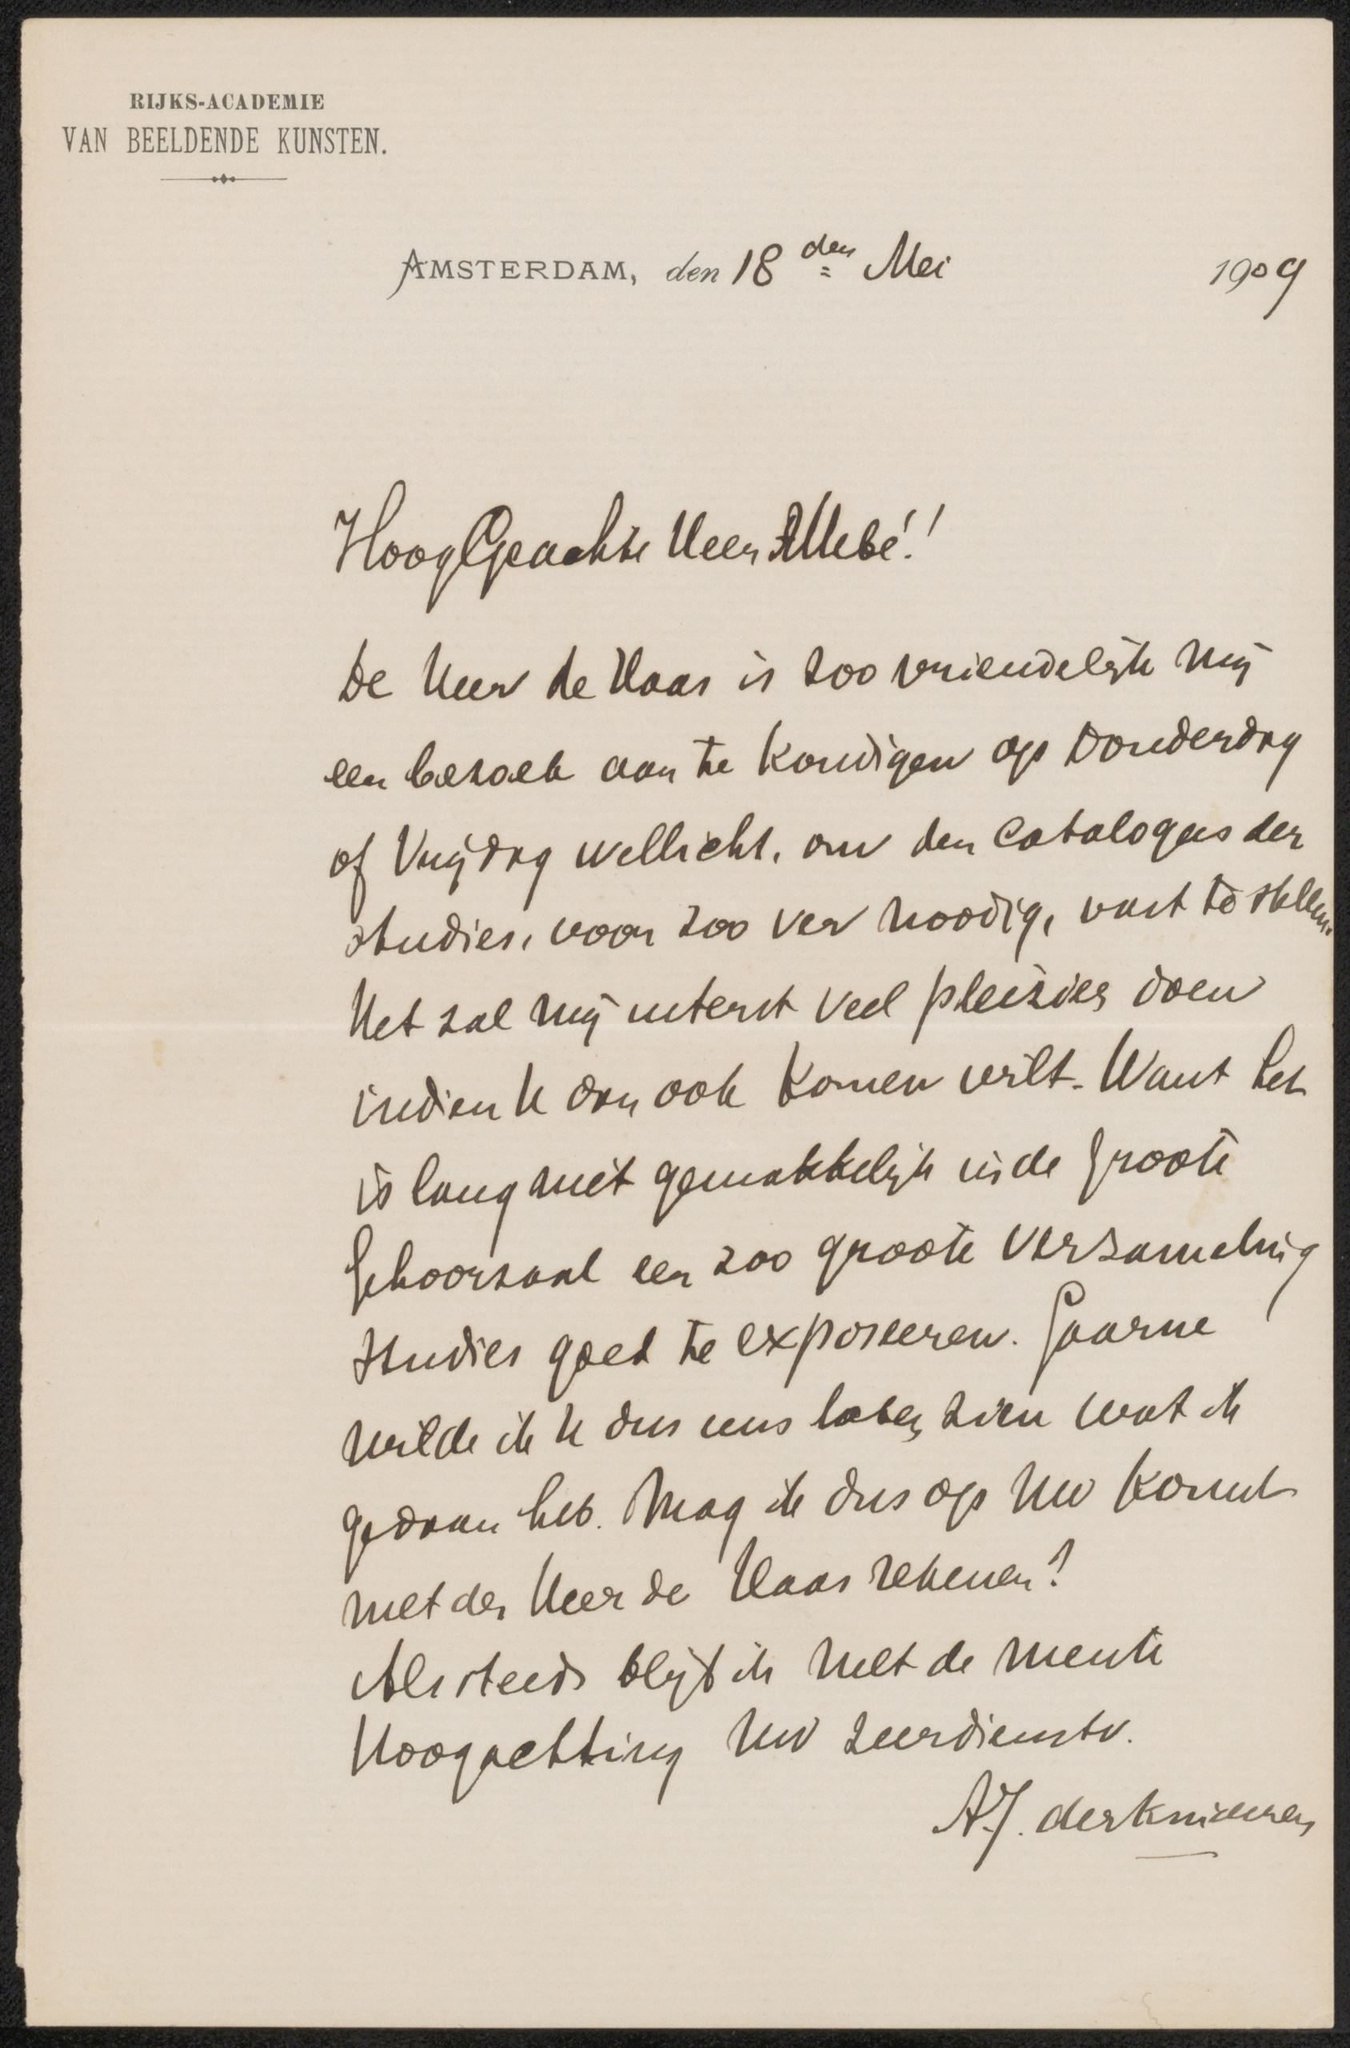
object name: letter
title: Brief aan August Allebé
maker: antoon derkinderen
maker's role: draughtsman, painter, print maker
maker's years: 1859-1925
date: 1909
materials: ink, paper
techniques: pen, printing, writing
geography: amsterdam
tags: august allebé, exhibition ~ art